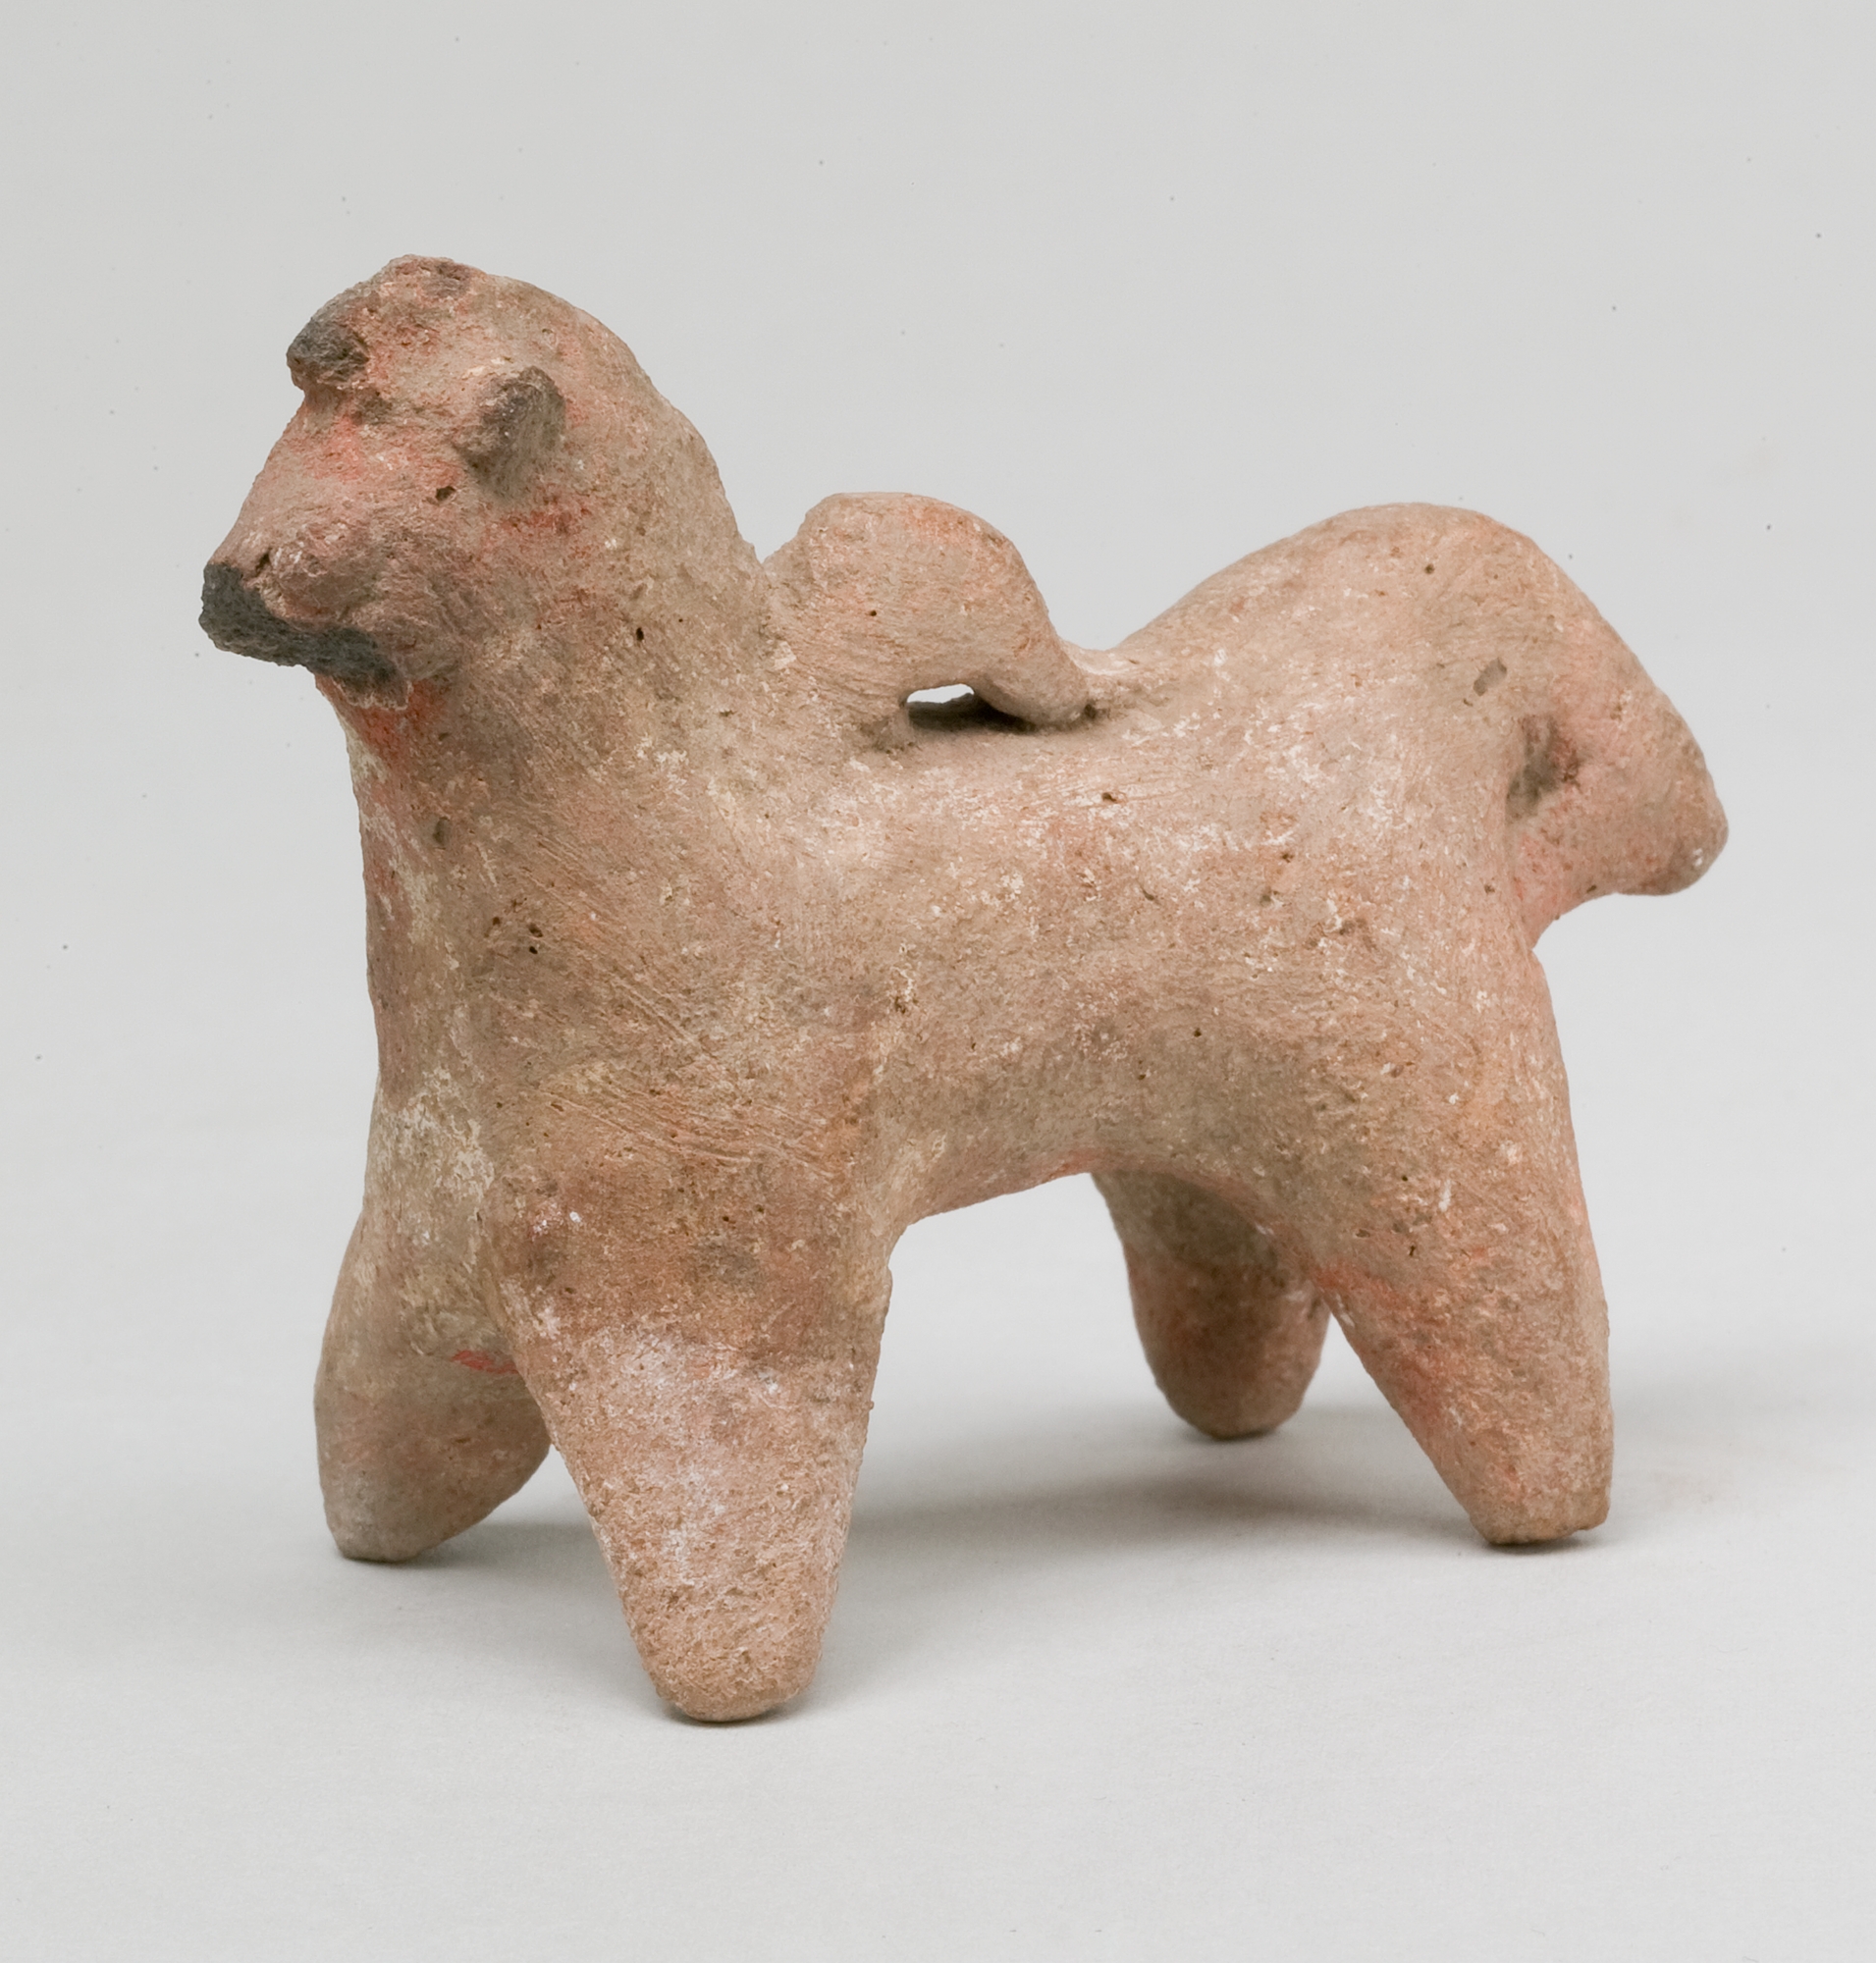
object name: figurine, donkey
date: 1550-1295 BCE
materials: paint, pottery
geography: egypt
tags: donkeys